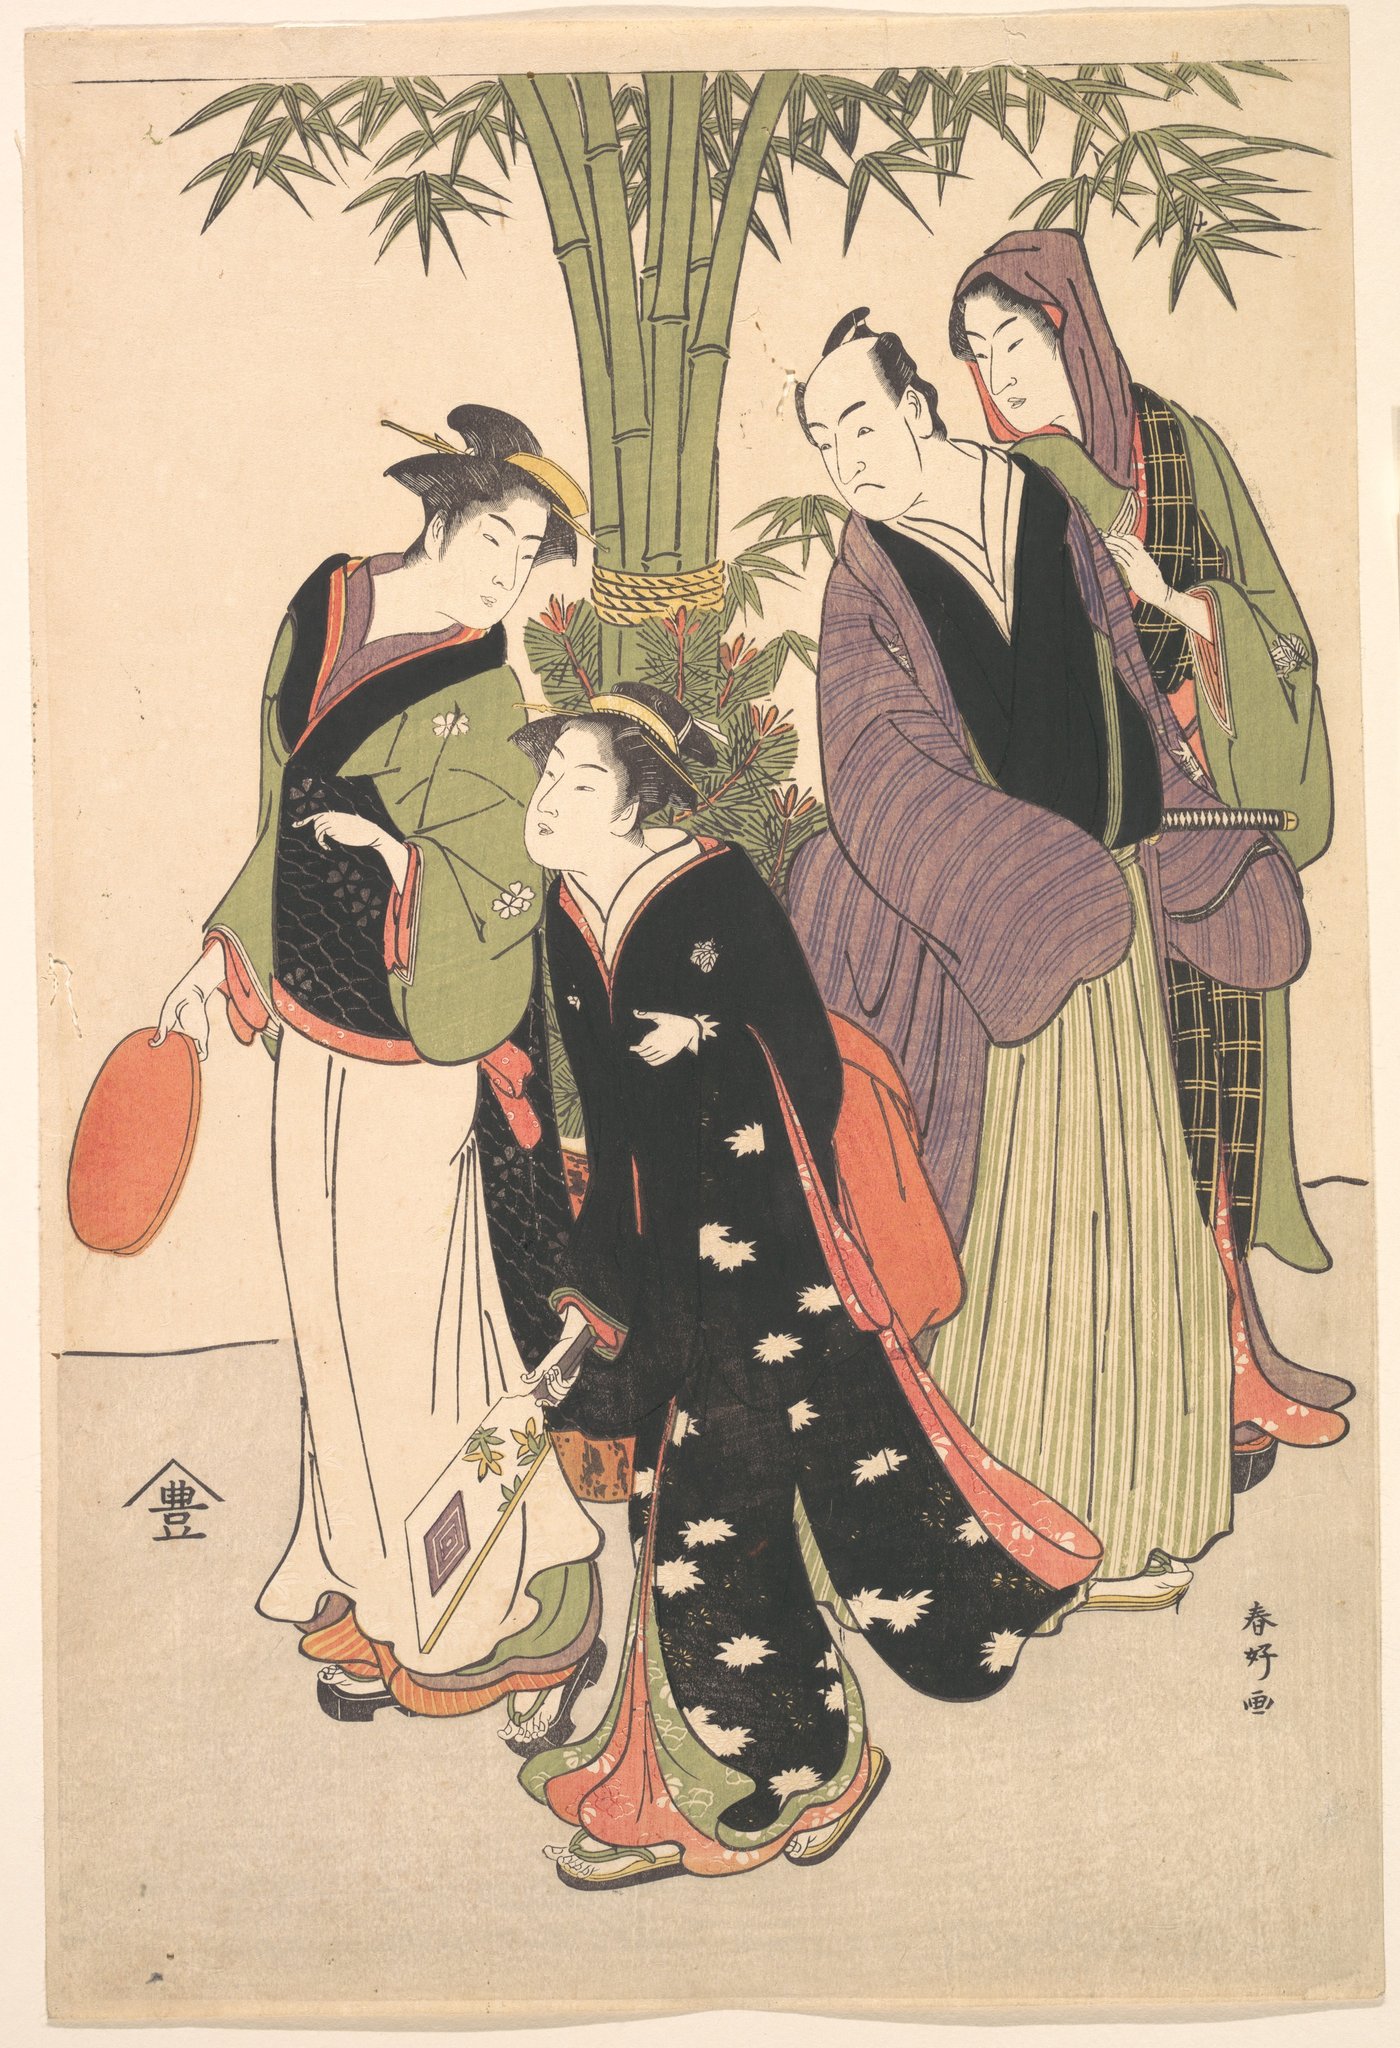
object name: print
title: Kabuki Actors Segawa Kikunojō III and Ichikawa Monnosuke II and Two Courtesans Celebrating the New Year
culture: japanese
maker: katsukawa shunkō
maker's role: artist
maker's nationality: japanese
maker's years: 1743-1812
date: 1790-1799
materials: ink, paper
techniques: woodblock print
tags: men,women,bamboo,actors